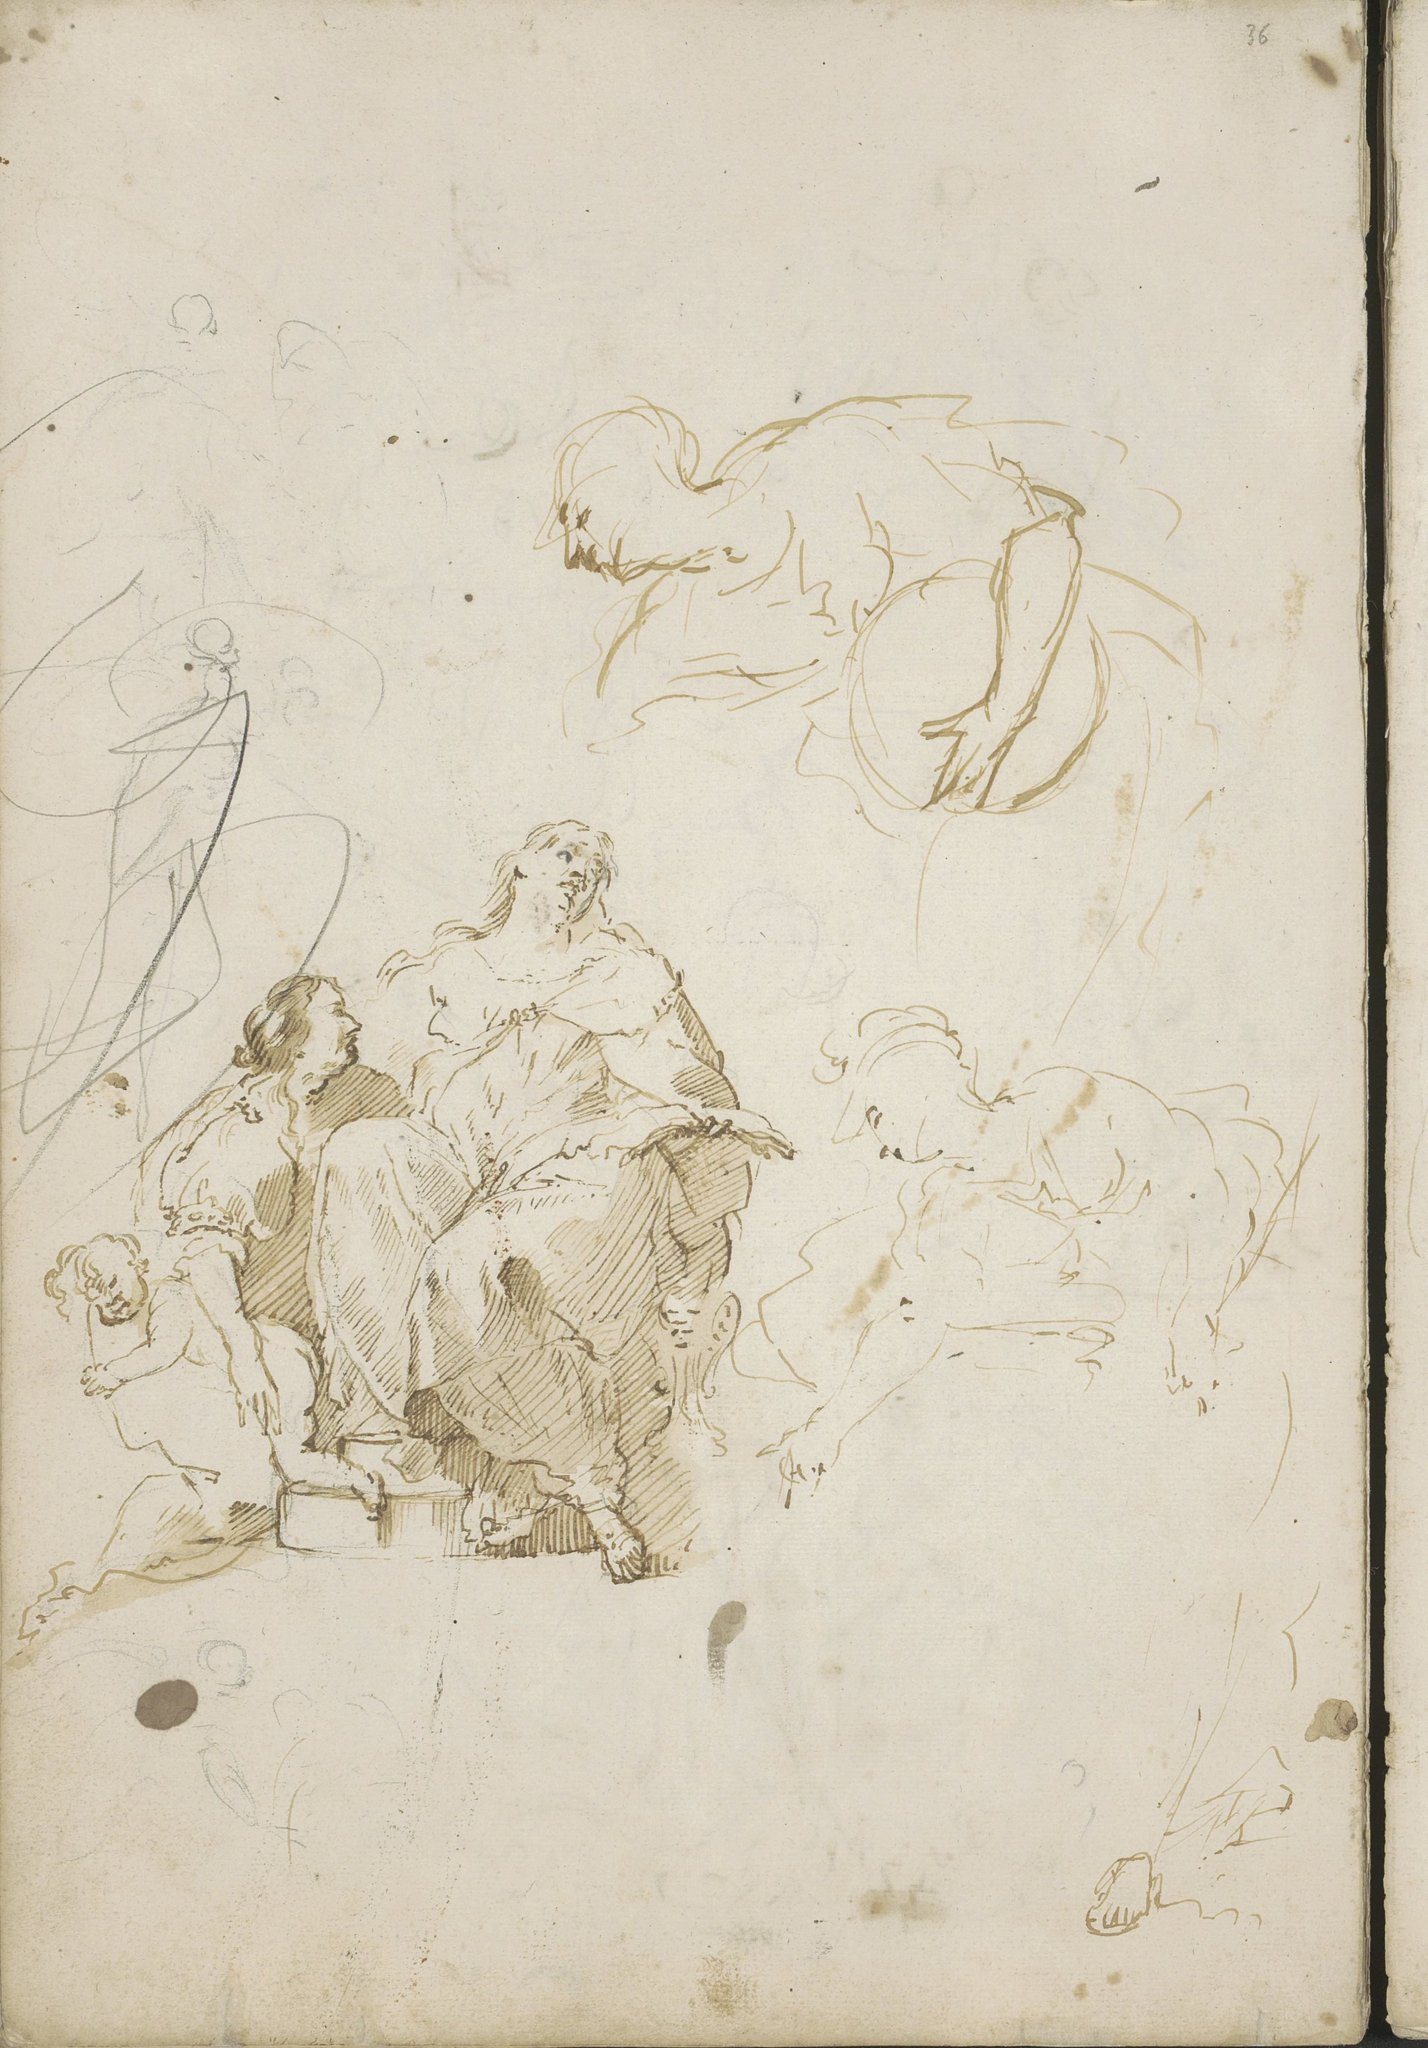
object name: sketchbook leaf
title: Zittende vrouw met opgeslagen ogen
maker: Anonymous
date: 1650-1799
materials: ink, paper, pencil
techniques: brush, pen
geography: italy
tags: sitting figure - aa - female human figure, cupids: 'amores', 'amoretti', 'putti', looking upwards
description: Naast de vrouw knielt een tweede vrouw en zit een putto. Tevens studies van een figuur die een bol onder de arm draagt. Bladzijde 36 uit een schetsboek met 72 bladzijden.